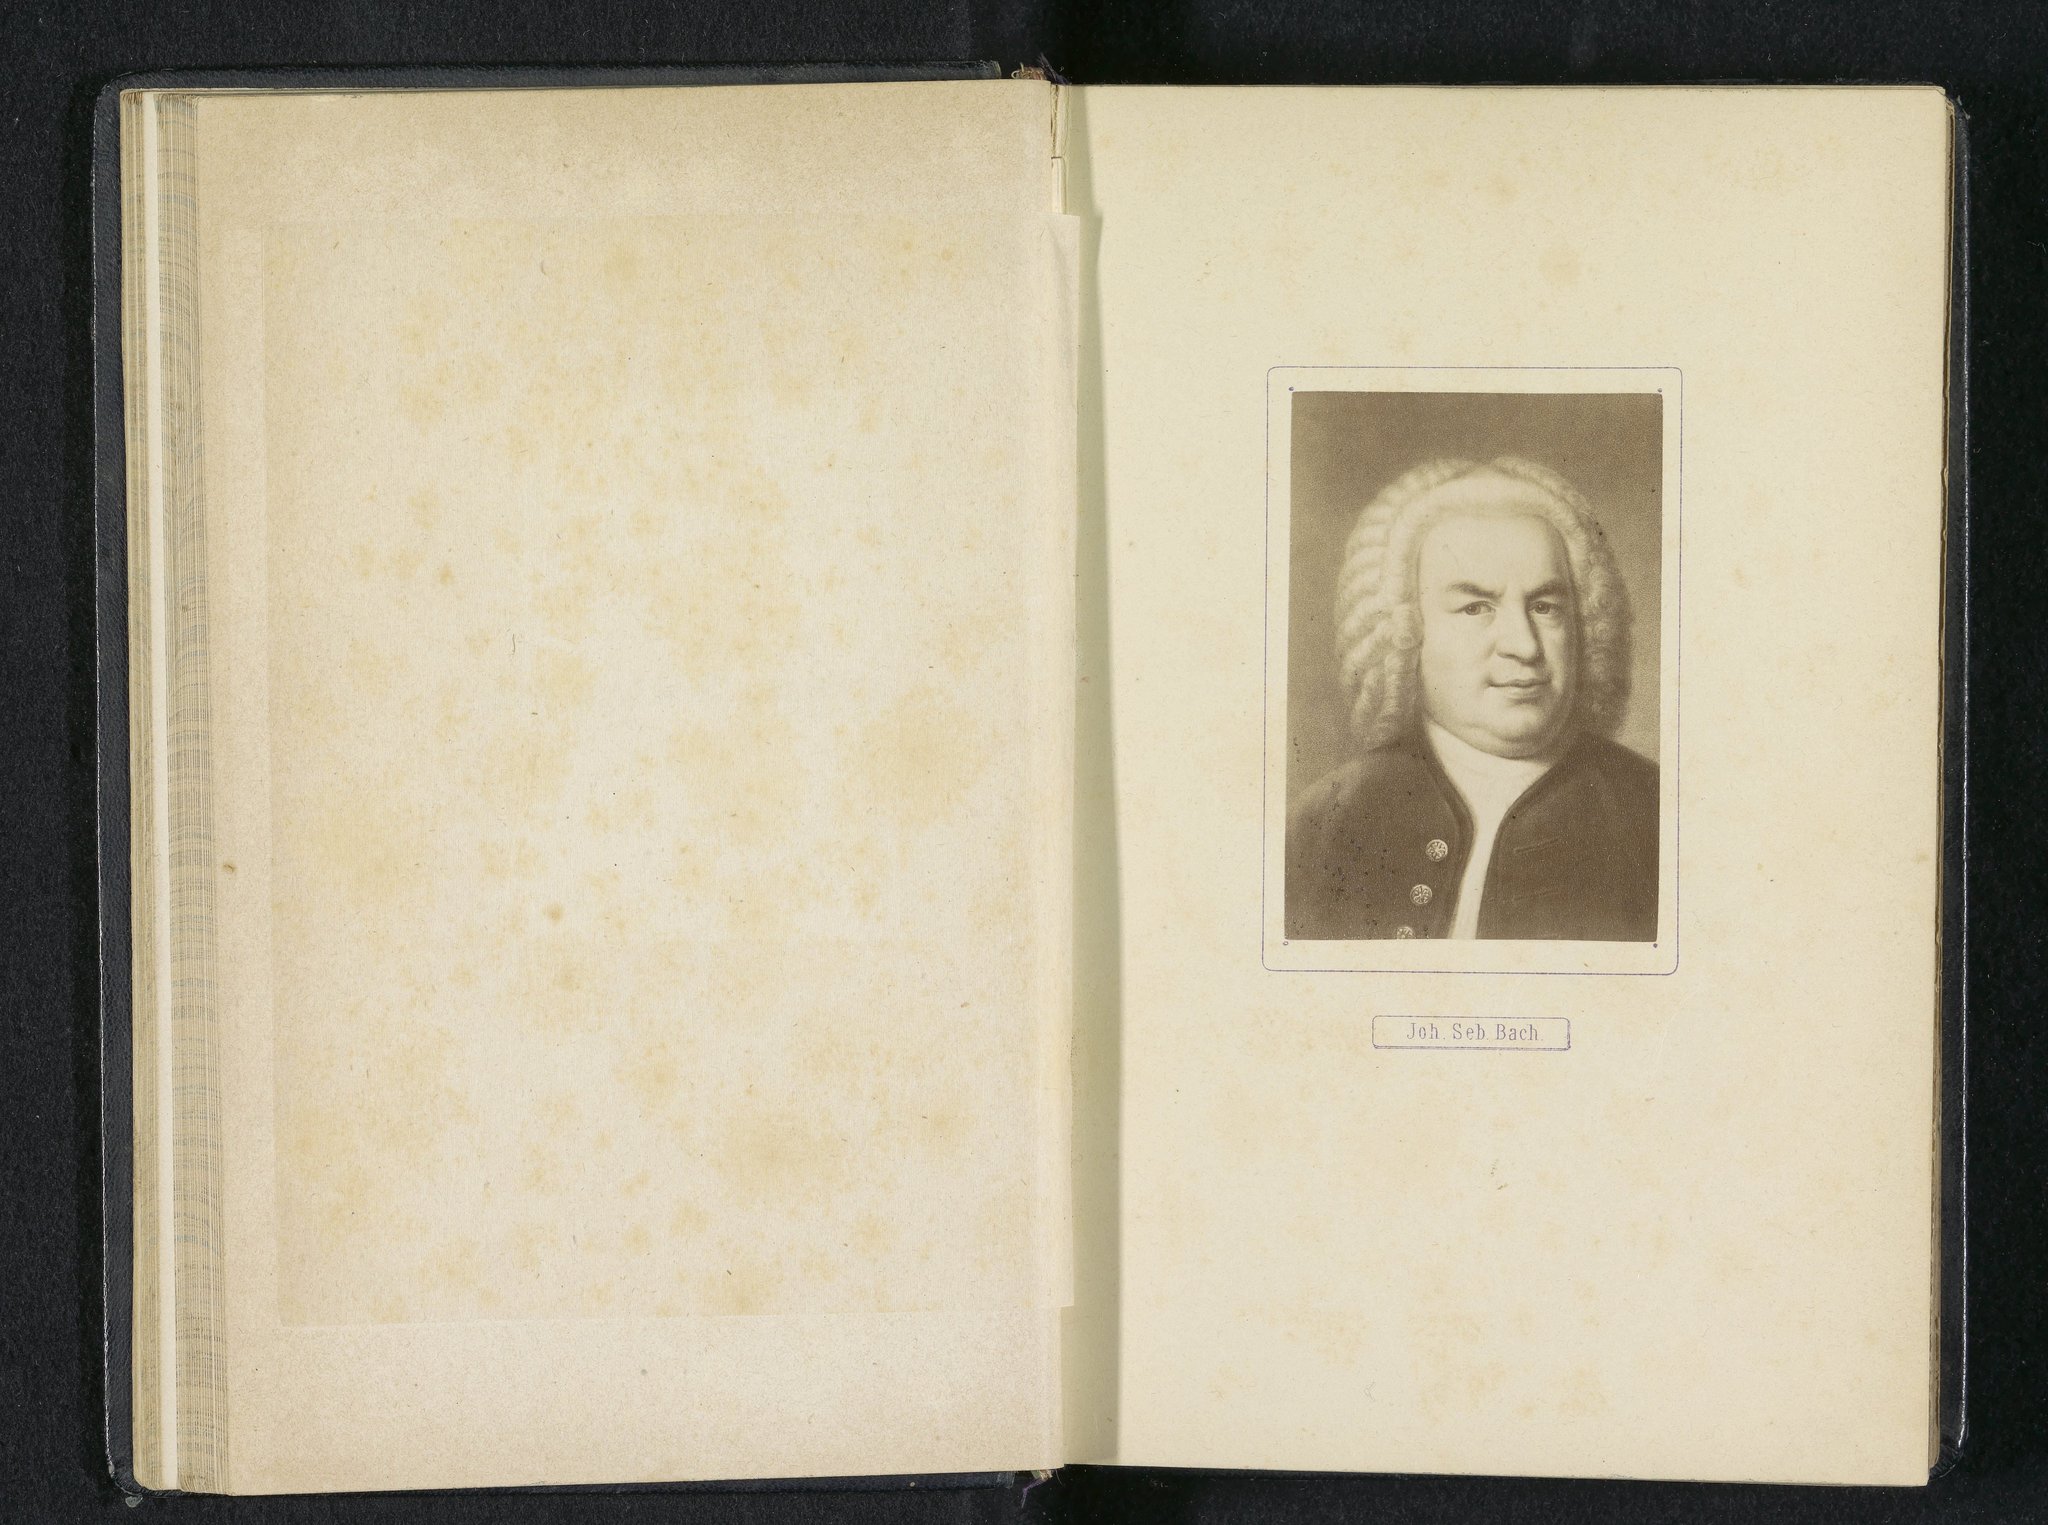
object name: page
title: Fotoreproductie van een portret van Johann Sebastian Bach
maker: Anonymous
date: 1866-1876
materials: photographic support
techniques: albumen print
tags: composer